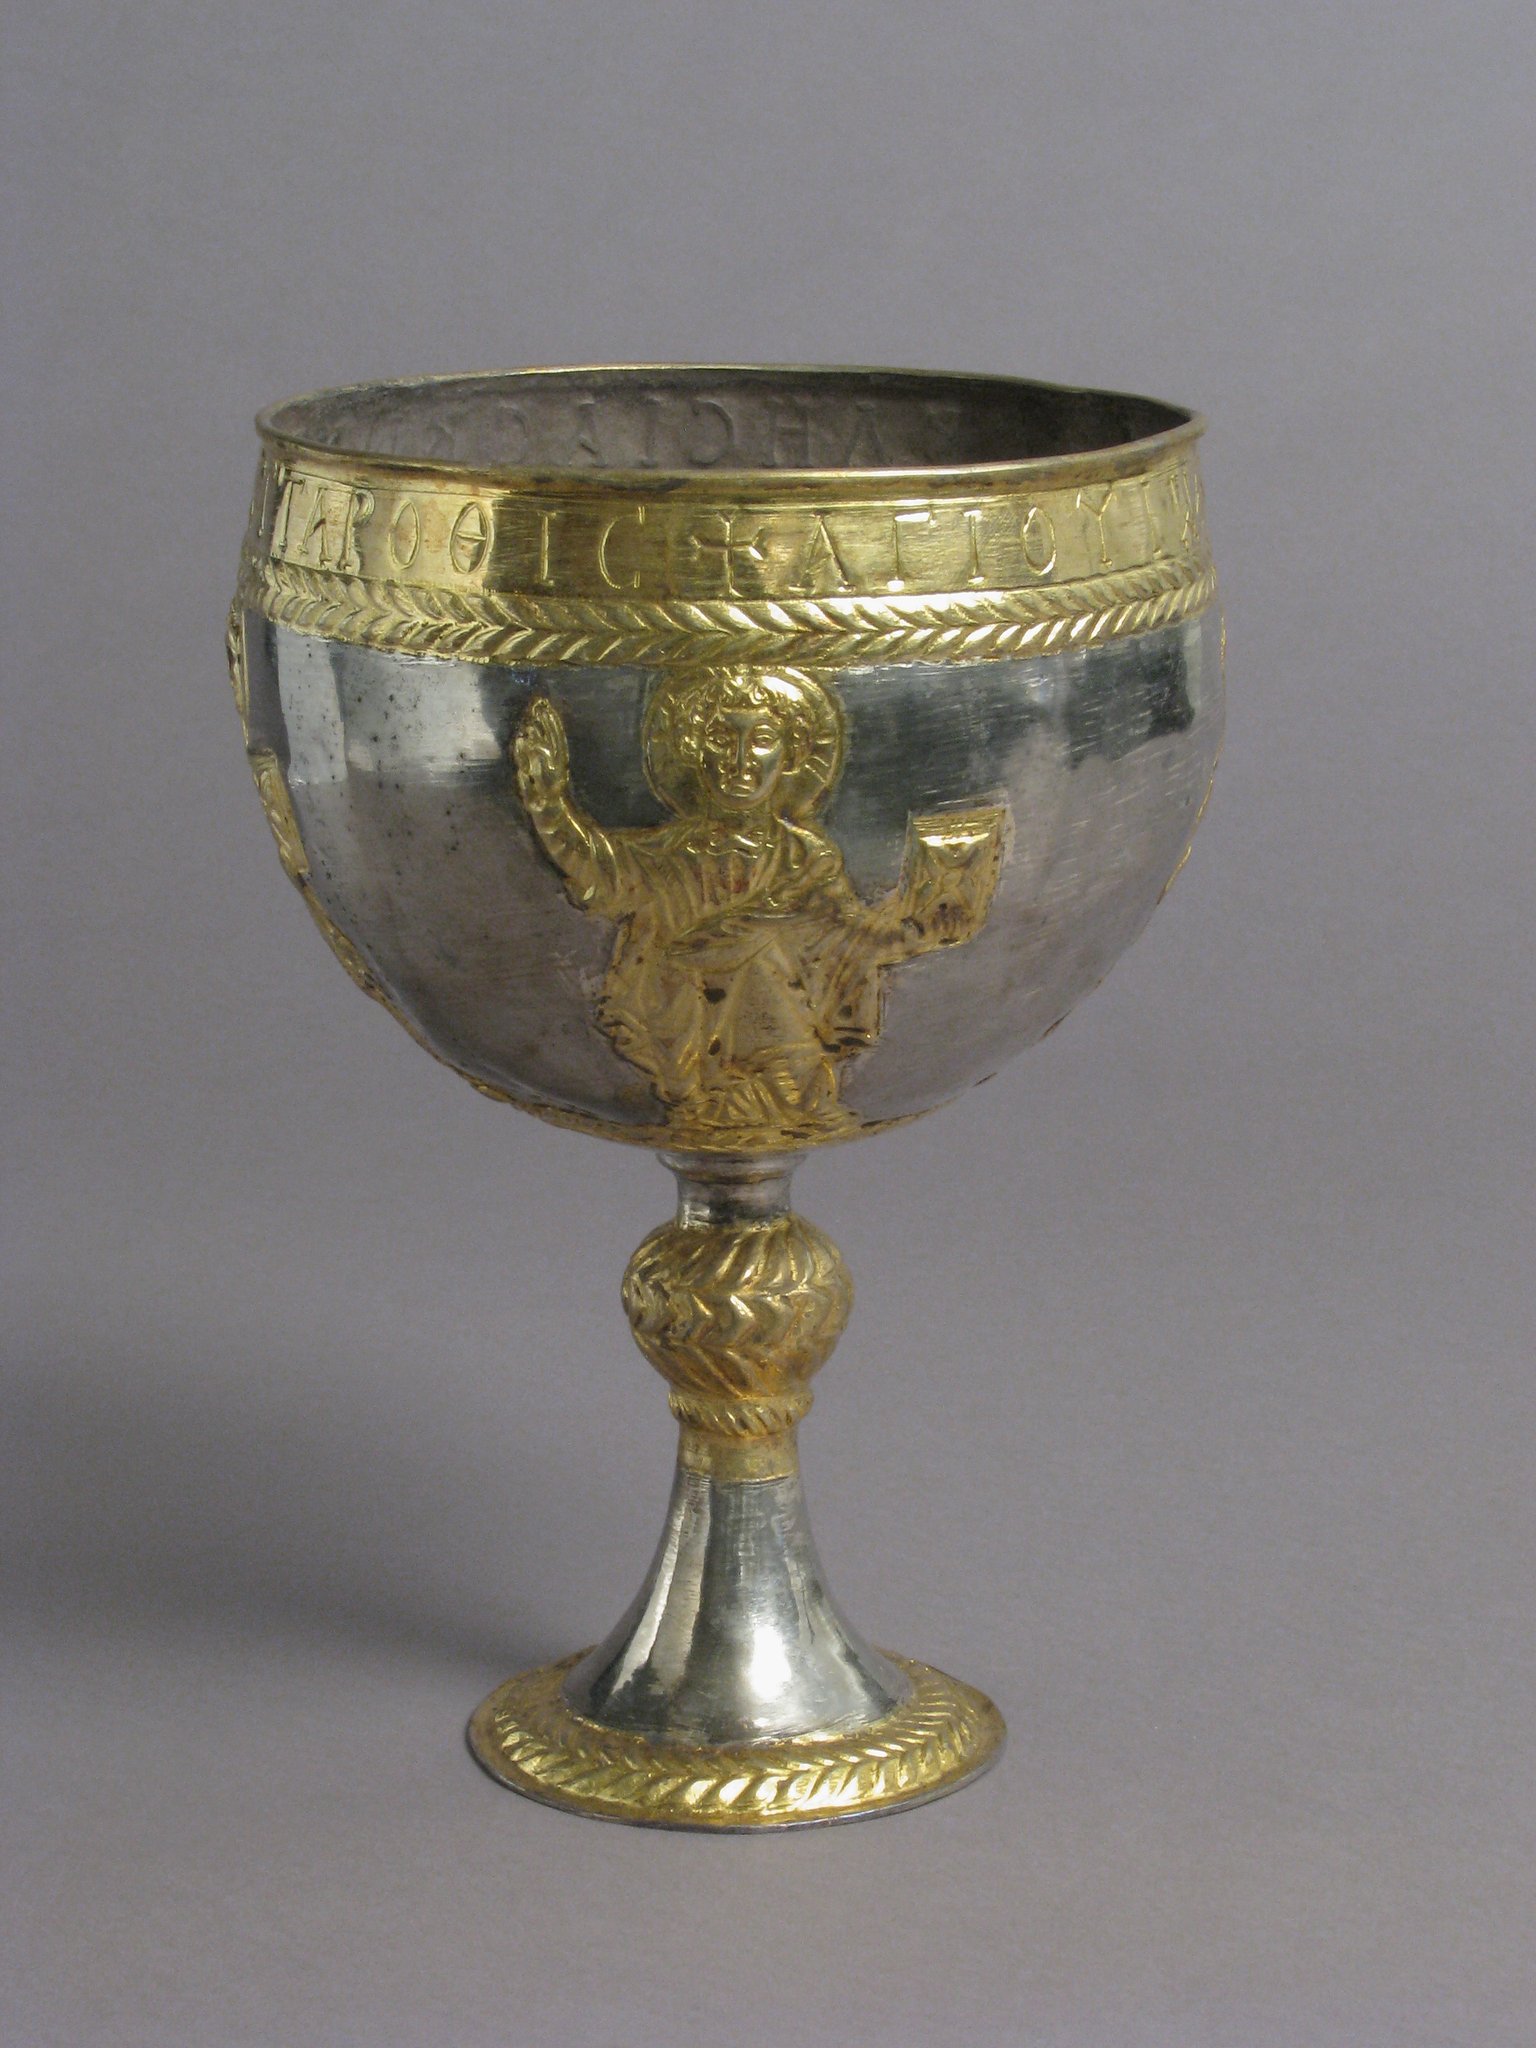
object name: chalice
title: The Attarouthi Treasure - Chalice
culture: byzantine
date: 500-650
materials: gilt silver, silver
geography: syria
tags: christ